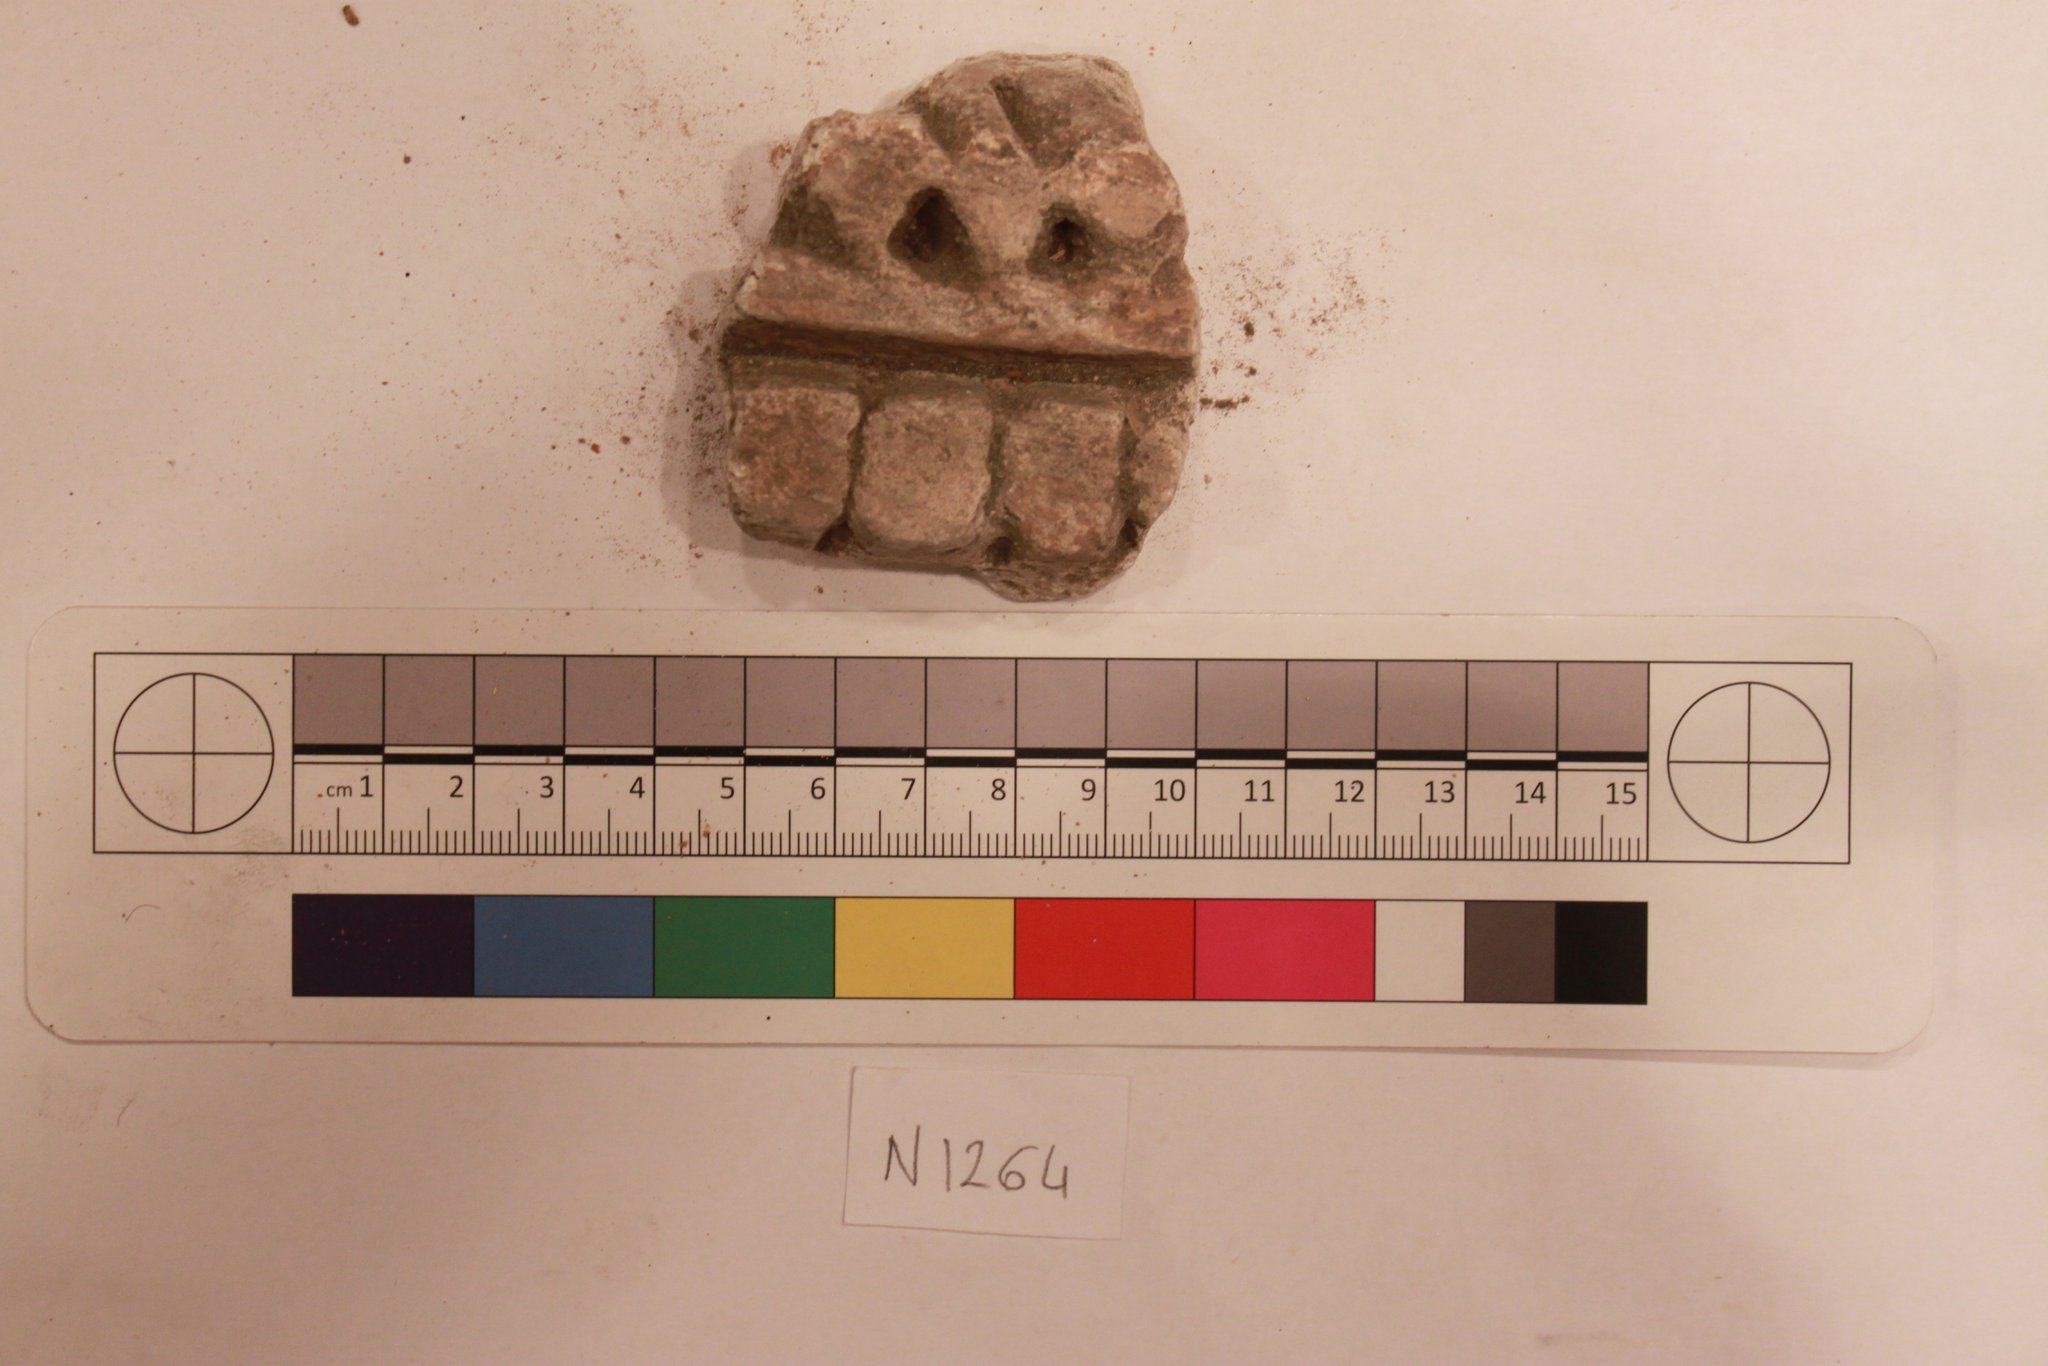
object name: fragment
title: Stucco Fragment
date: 701-1200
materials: plaster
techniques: carving, painting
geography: iran